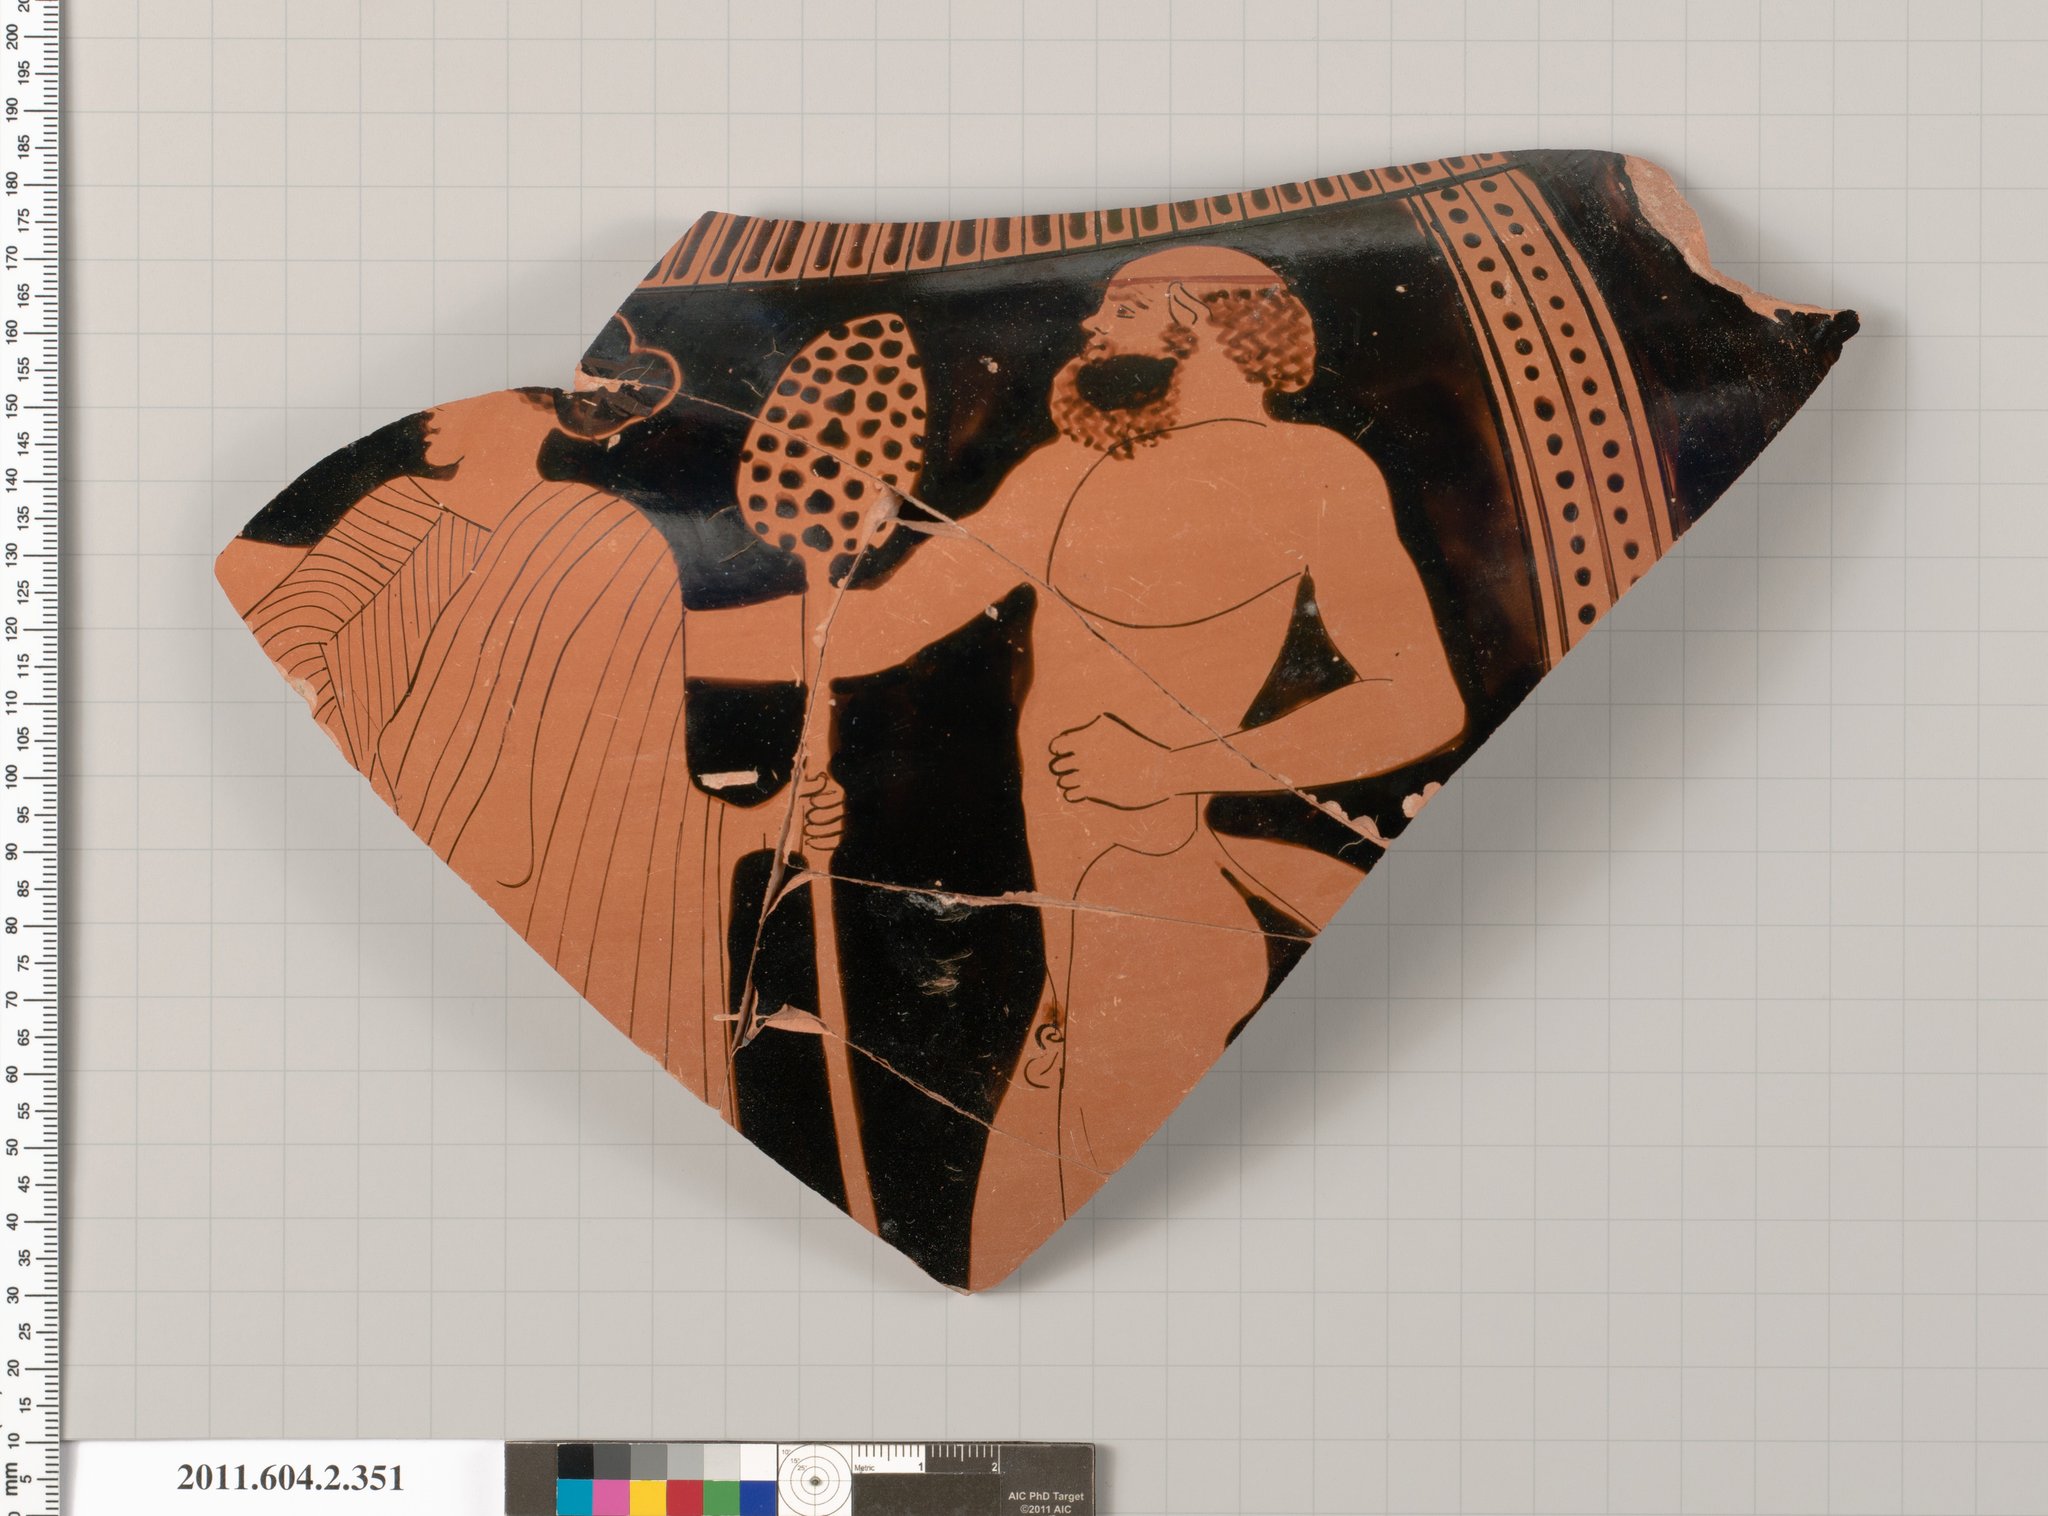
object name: column krater fragment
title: Terracotta fragment of a column-krater (bowl for mixing wine and water)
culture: greek, attic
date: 460-440 BCE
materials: terracotta